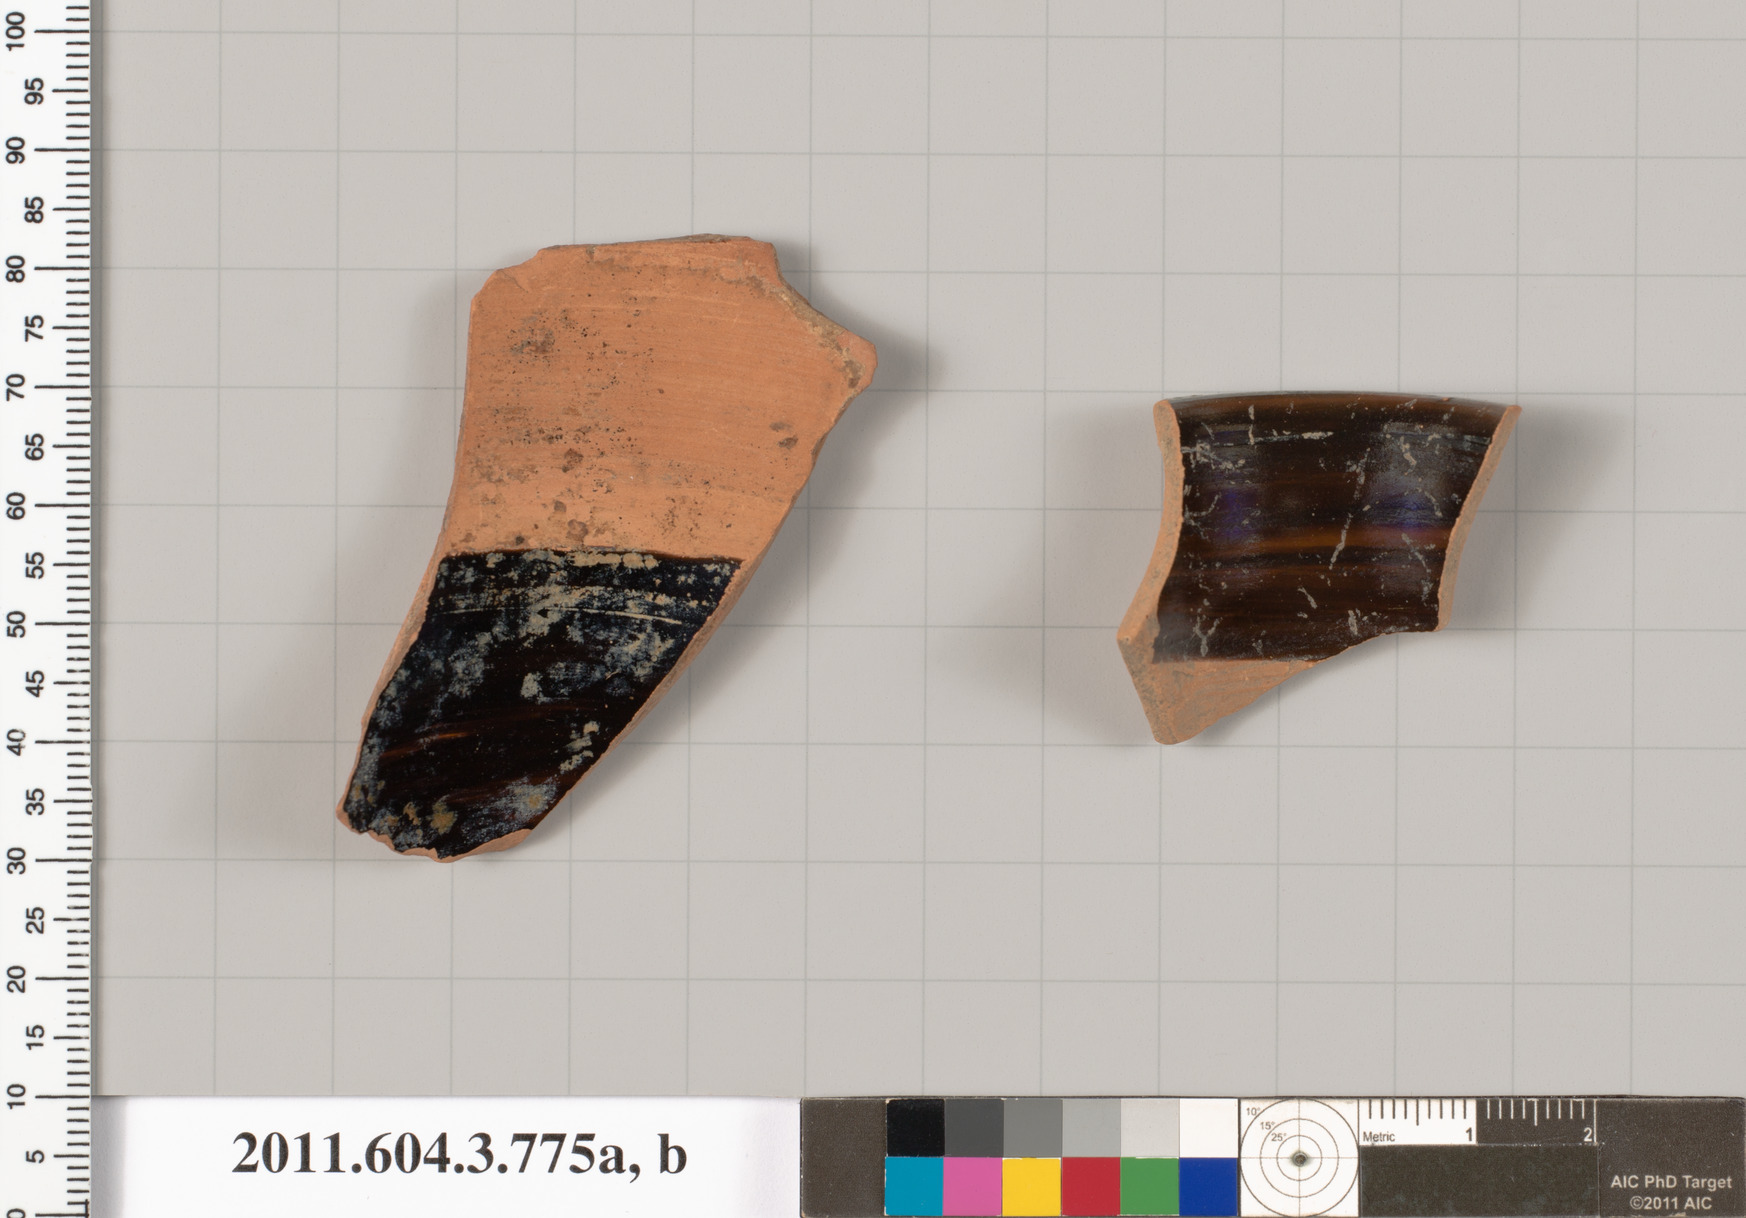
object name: olpe fragment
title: Terracotta fragments of an oinochoe: olpe (jug)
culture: greek, attic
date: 534-468 BCE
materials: terracotta